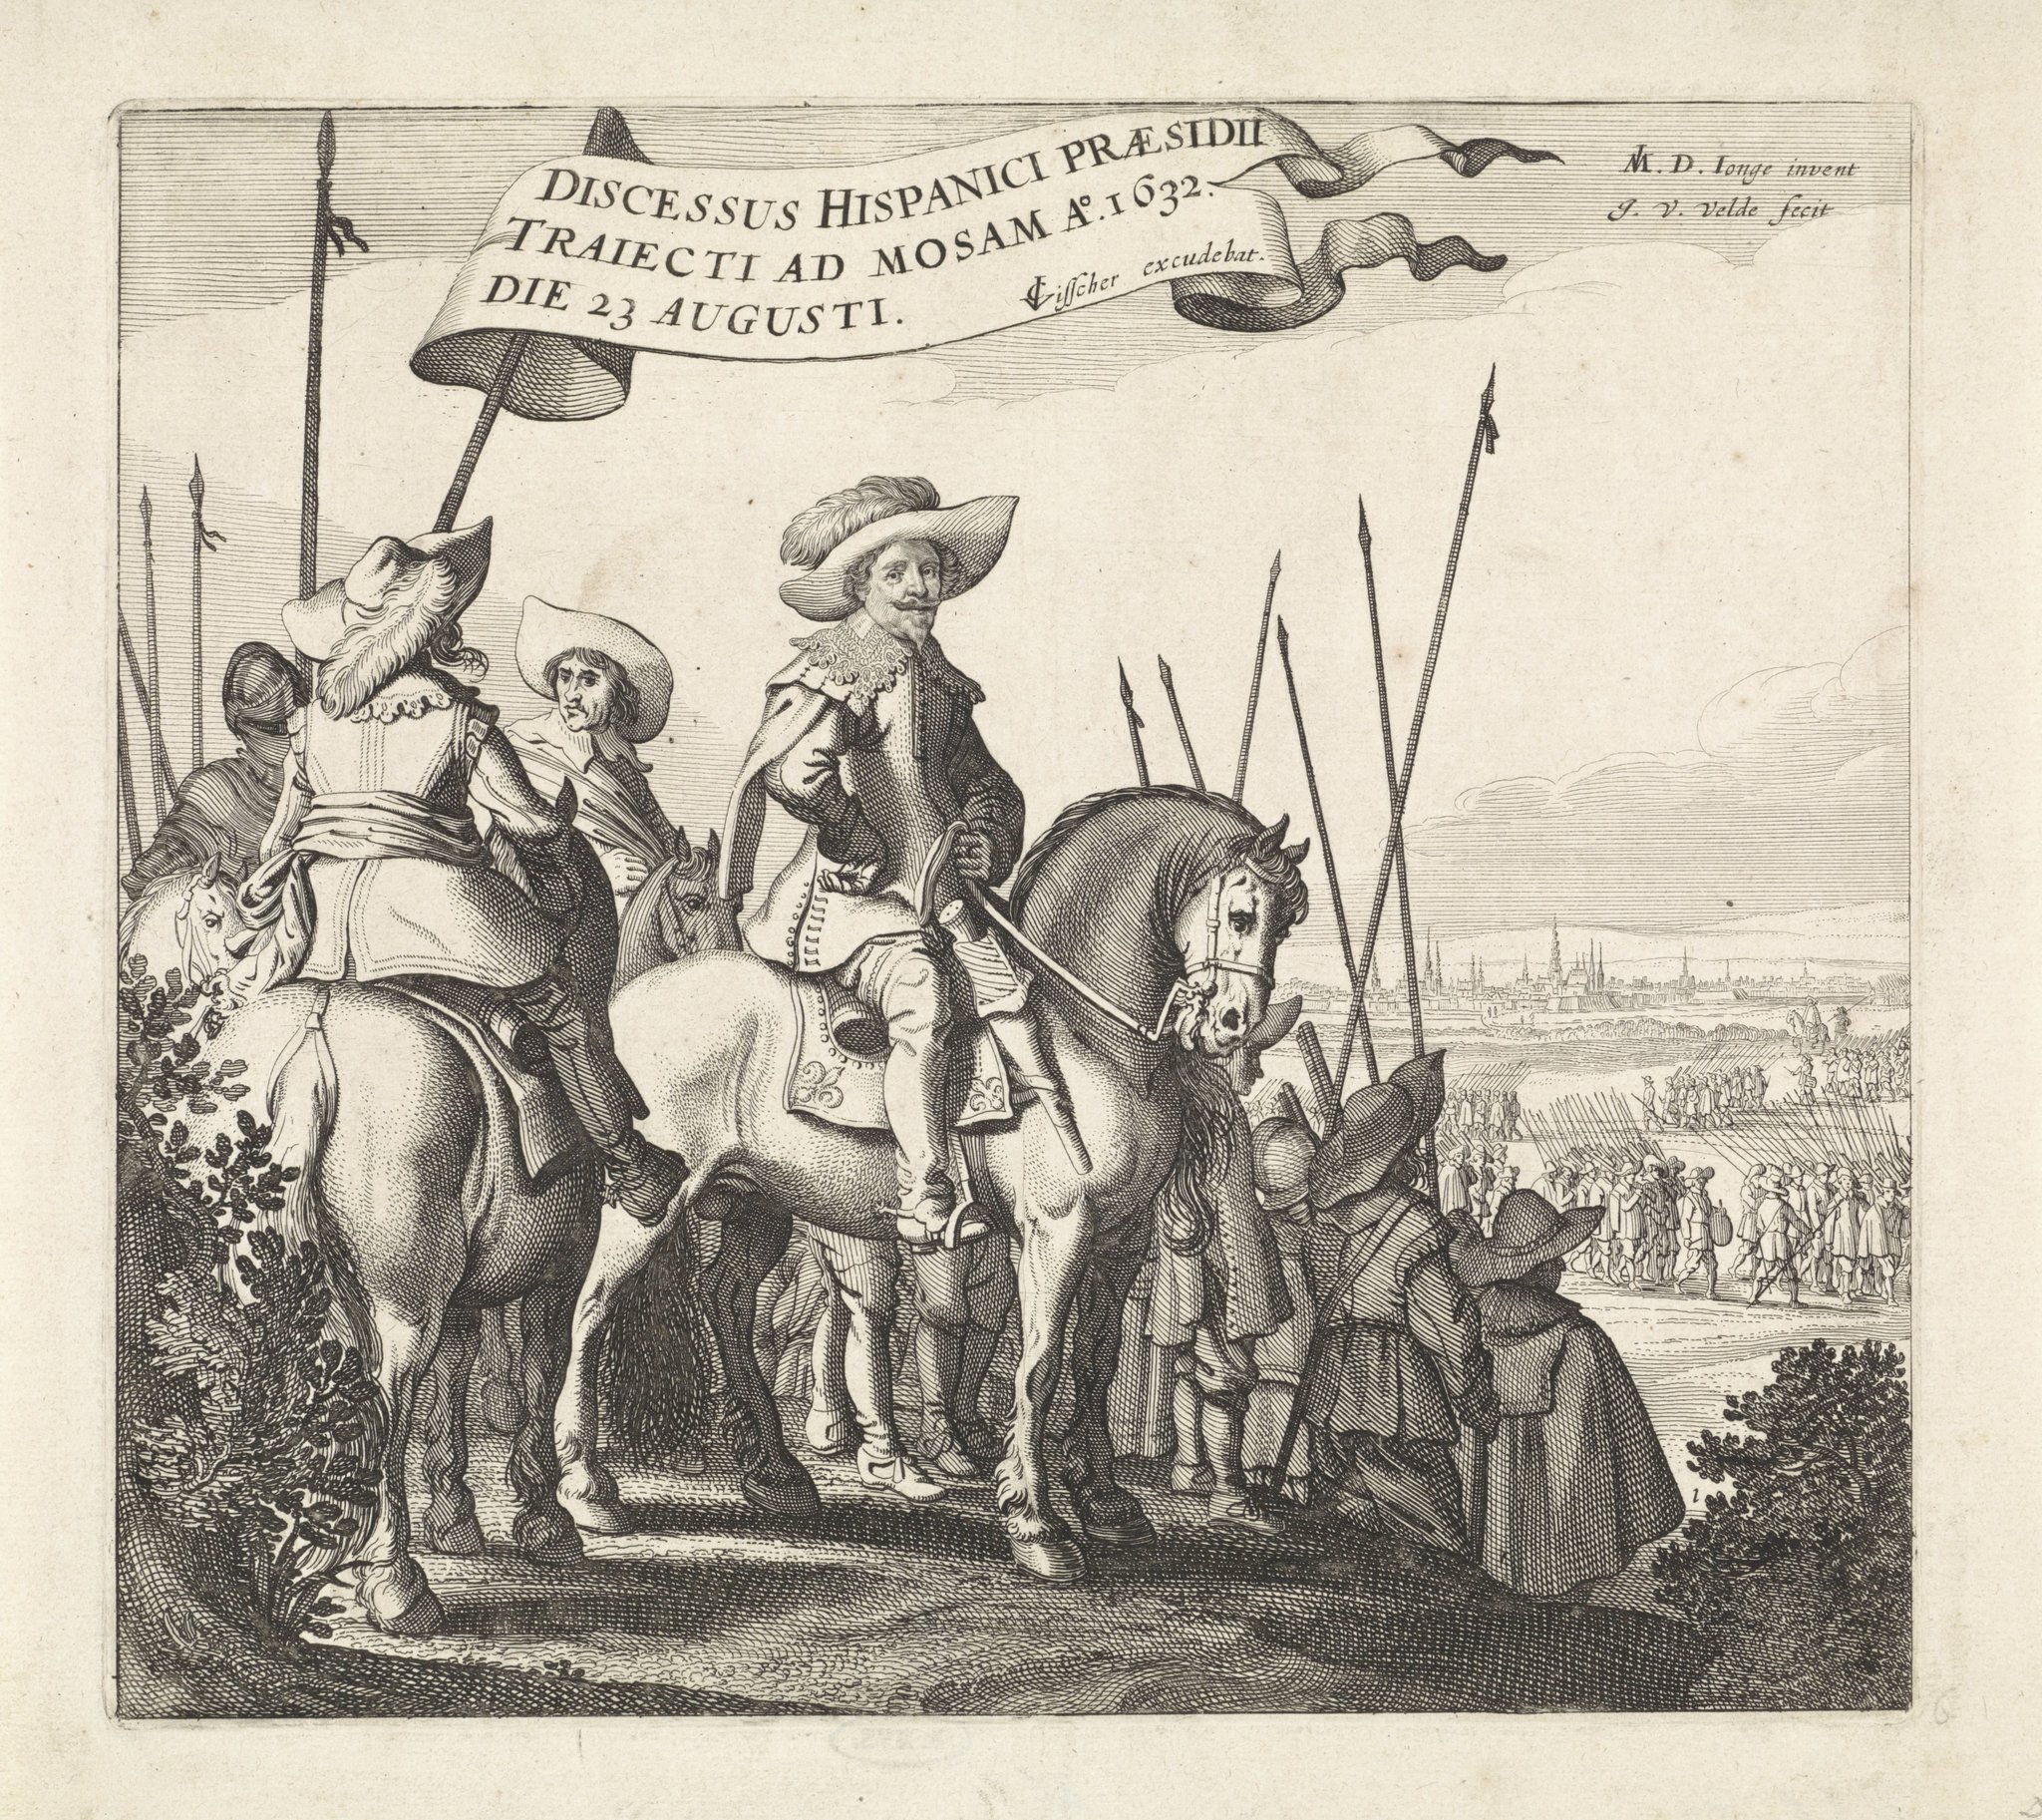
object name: titelprent, frontispice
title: Frederik Hendrik, prins van Oranje, te paard bij het verlaten van de Spanjaarden uit Maastricht, 1632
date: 1632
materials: paper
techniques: etching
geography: amsterdam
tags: delft, the hague, frederick henry (prince of orange), retreat of the defeated, maastricht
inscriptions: collector's mark: Lugt 964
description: Stadhouder Frederik Hendrik te paard, vergezeld door drie officieren en infanterie, het voorbij marcheren van de Spanjaarden gade slaand. Maastricht op de achtergrond. Eerste prent uit een fries van zes genummerde prenten met het Spaanse garnizoen dat Maastricht in 1632 verlaat.